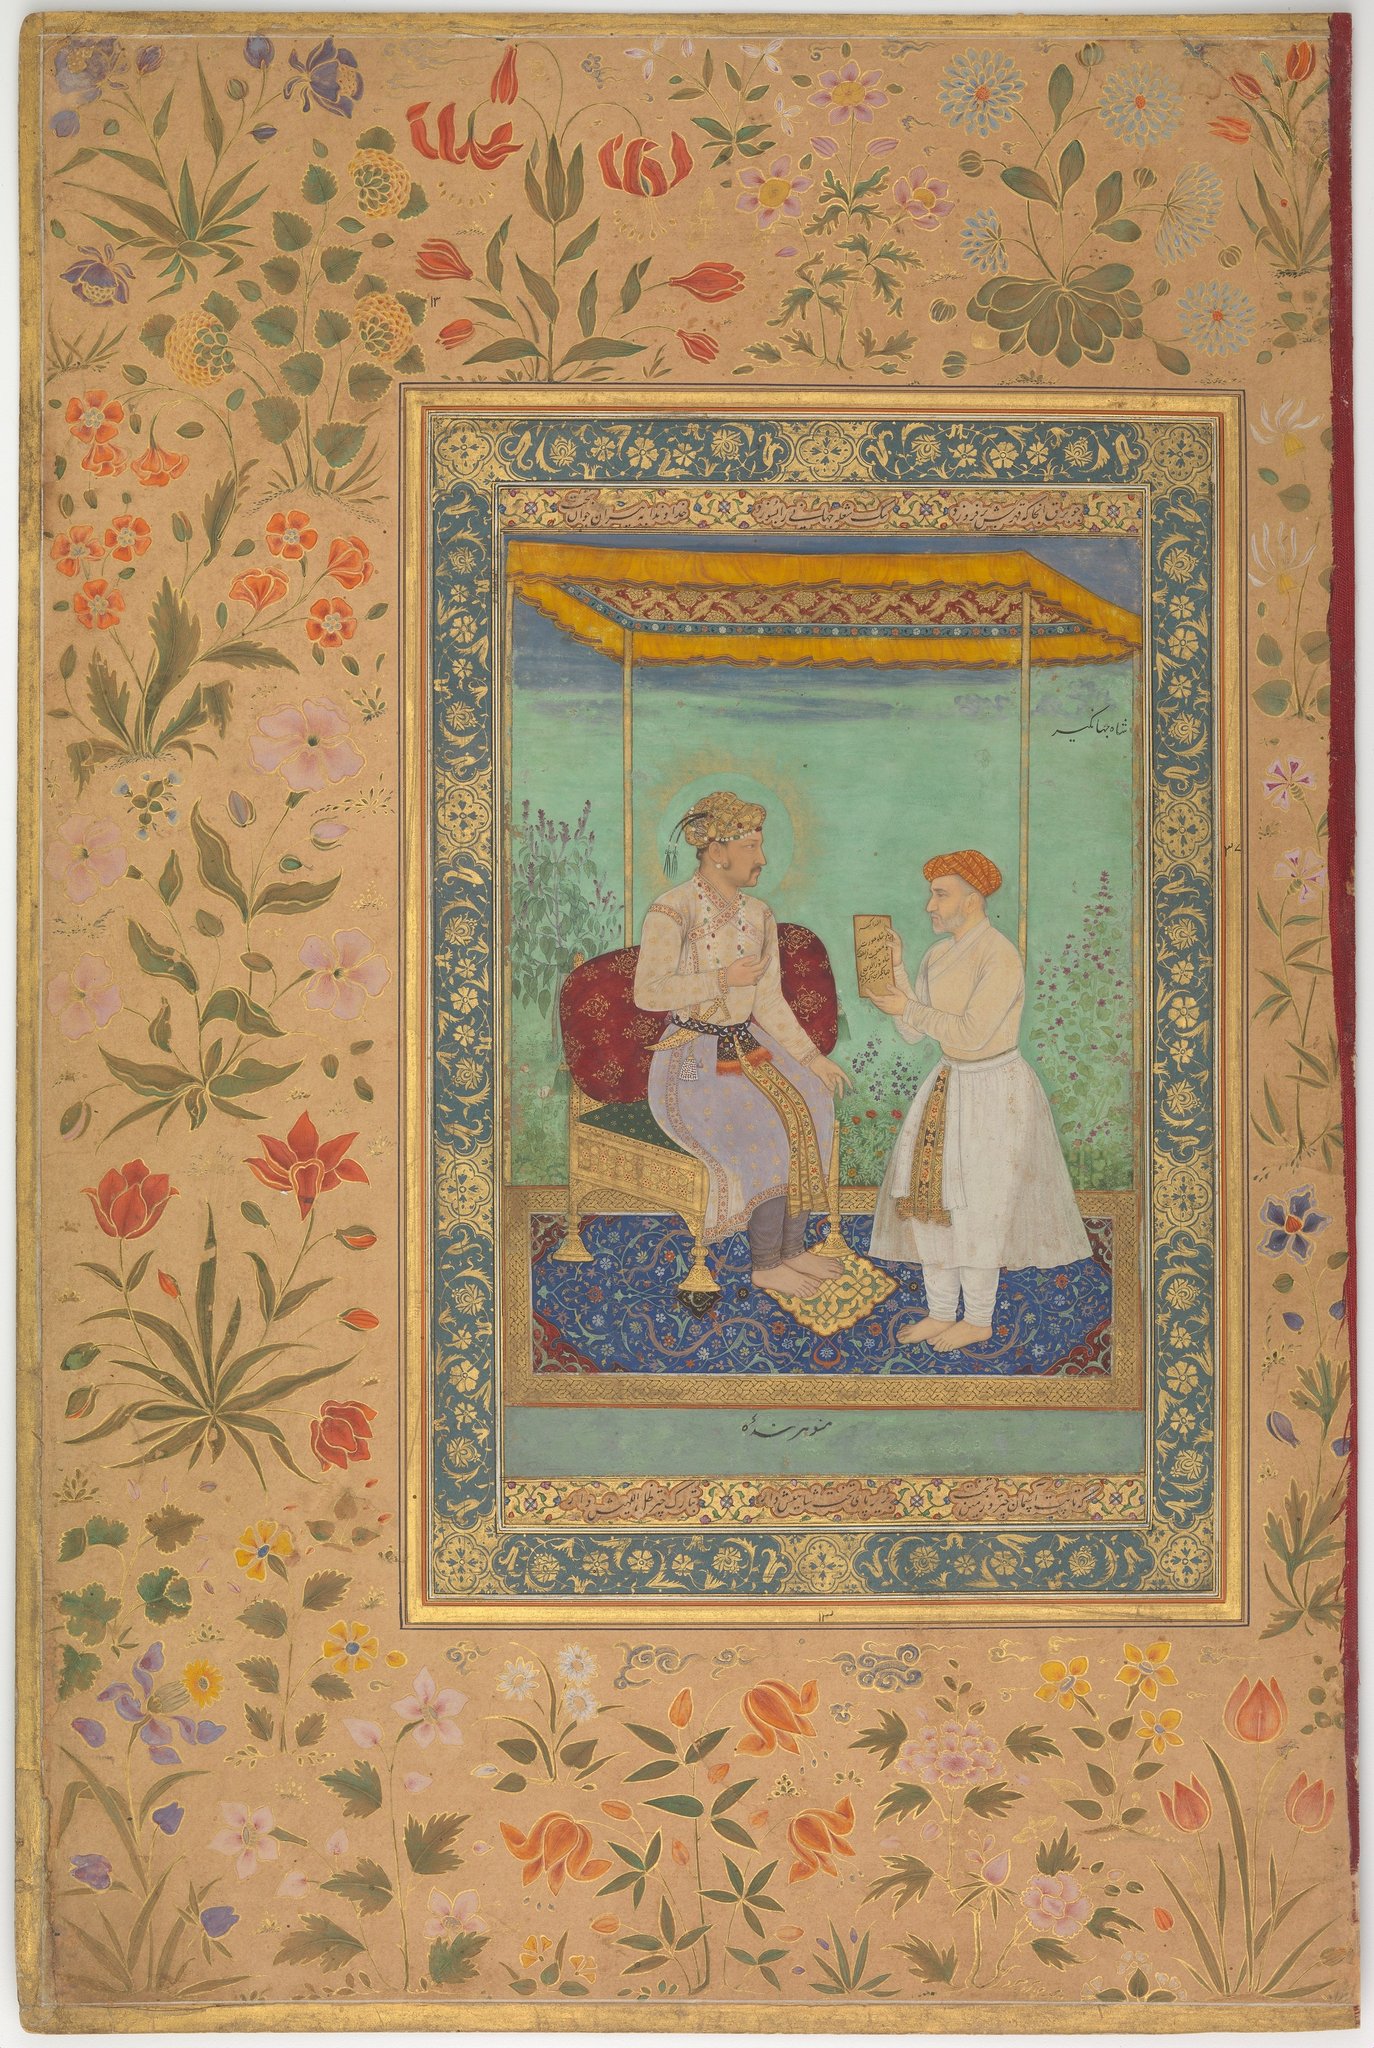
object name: album leaf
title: "Jahangir and His Vizier, I'timad al-Daula", Folio from the Shah Jahan Album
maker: manohar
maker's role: artist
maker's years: 1577-1624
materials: gold, ink, paper, watercolor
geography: india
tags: men